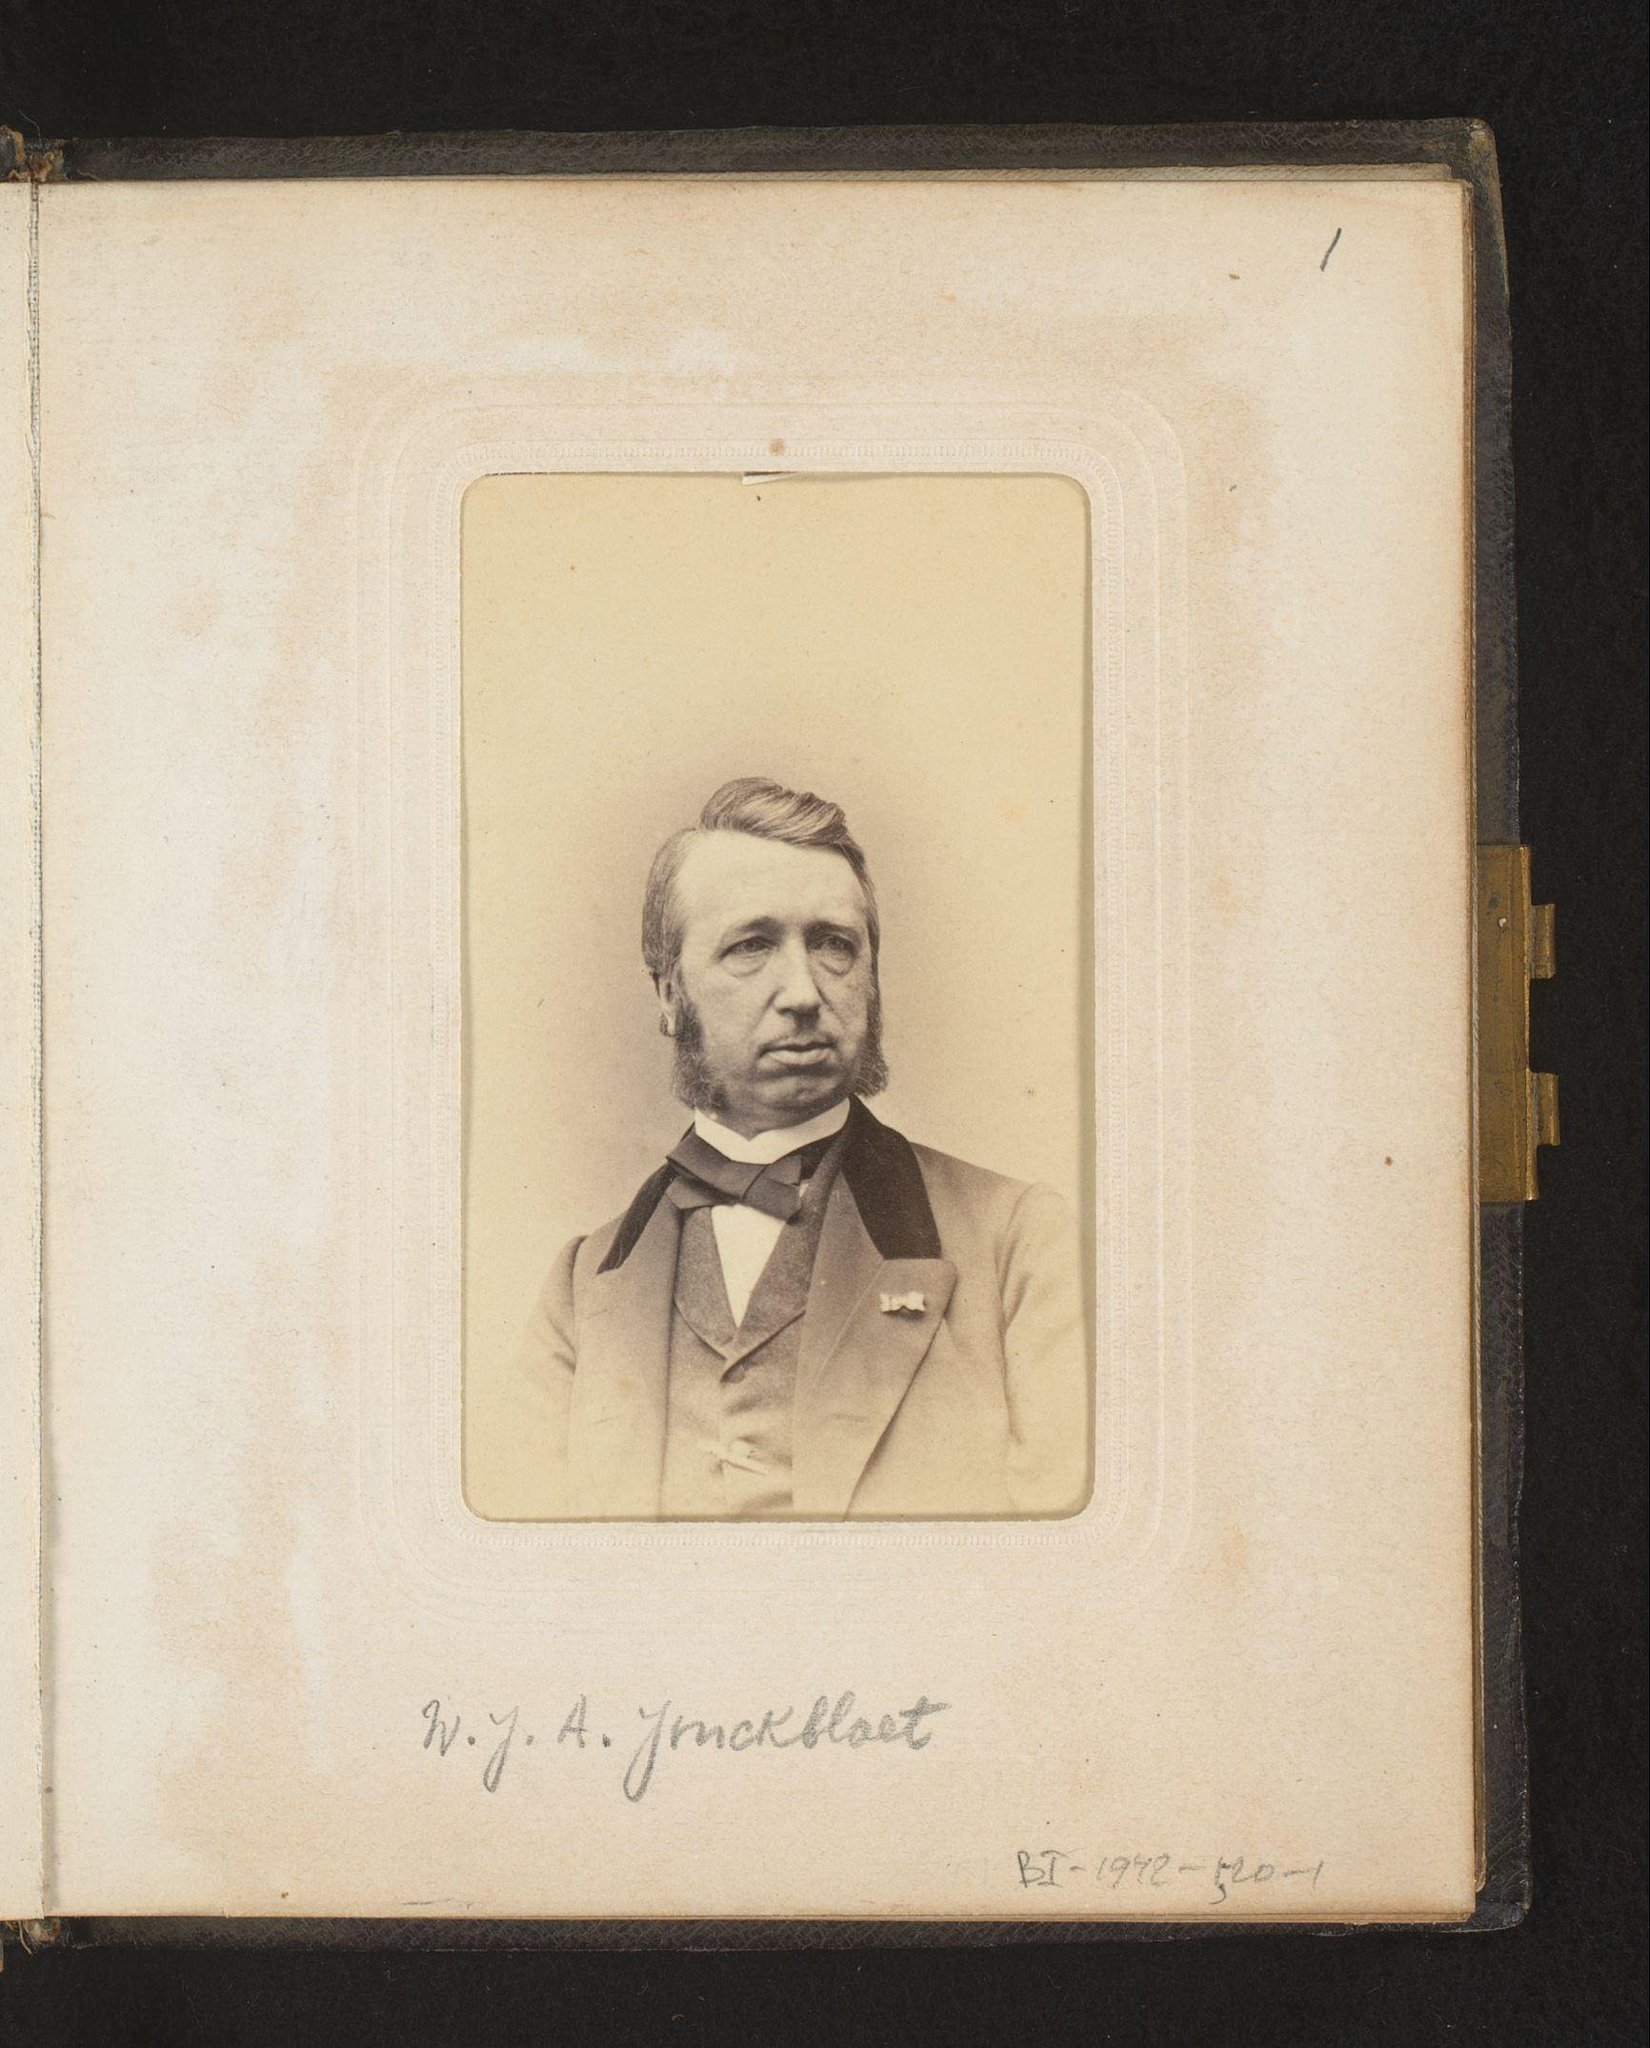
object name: carte de visite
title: Portret van Willem Joseph Andries Jonckbloet, hoogleraar in de faculteit Wijsbegeerte en Letteren aan de universiteit van Groningen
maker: johannes hinderikus egenberger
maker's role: draughtsman, print maker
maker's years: 1822-1897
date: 1864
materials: cardboard, paper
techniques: albumen print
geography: groningen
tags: the hague, historical persons, professor, groningen (province)